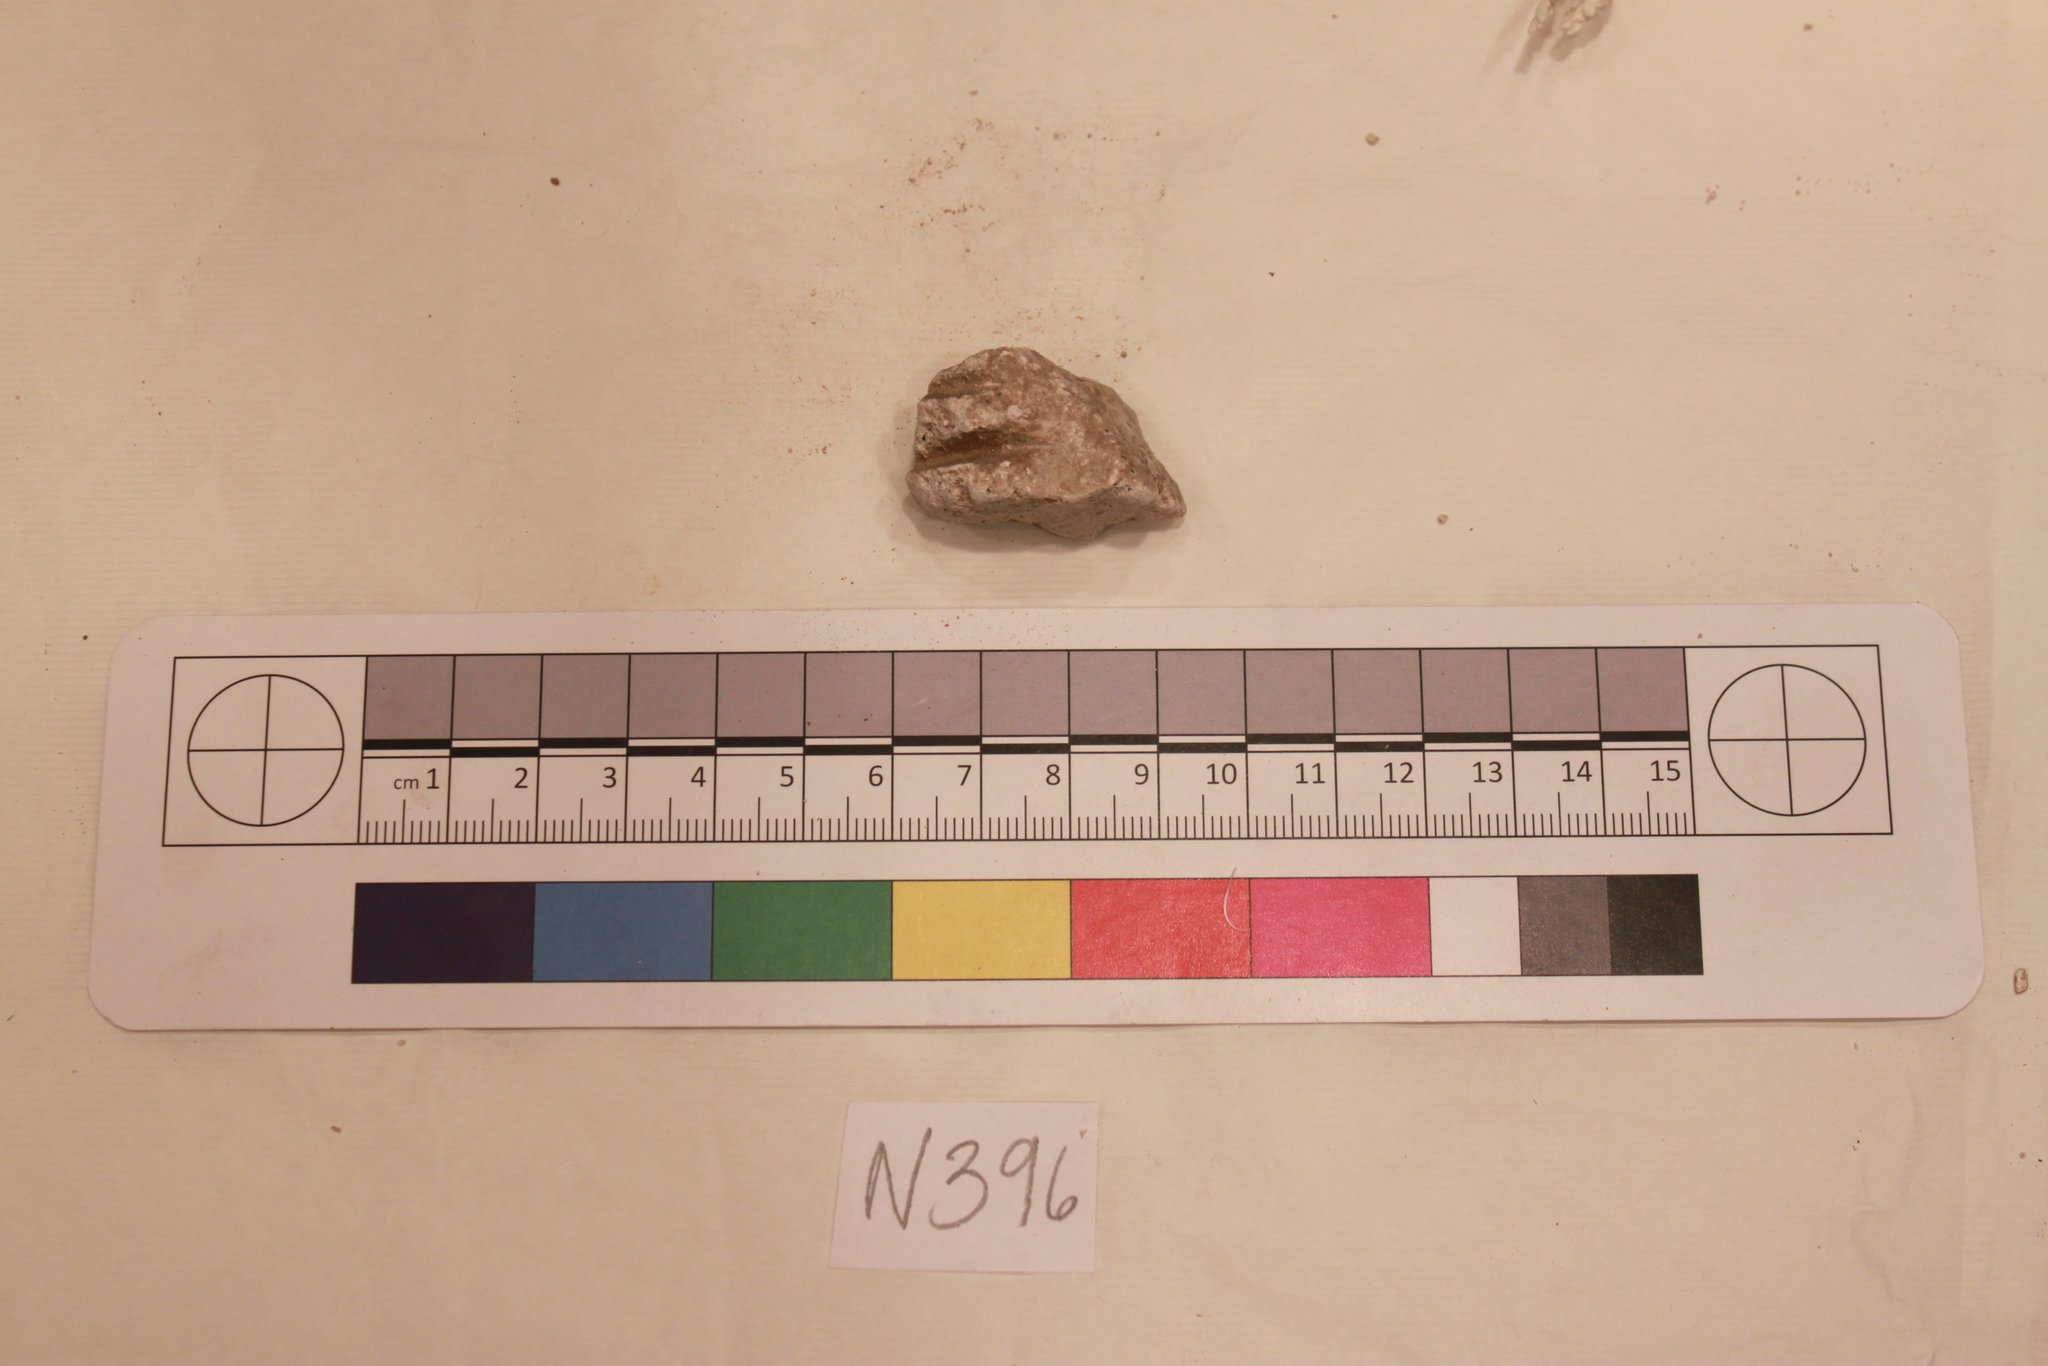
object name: fragment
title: Stucco Fragment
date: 701-1200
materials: plaster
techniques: carving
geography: iran